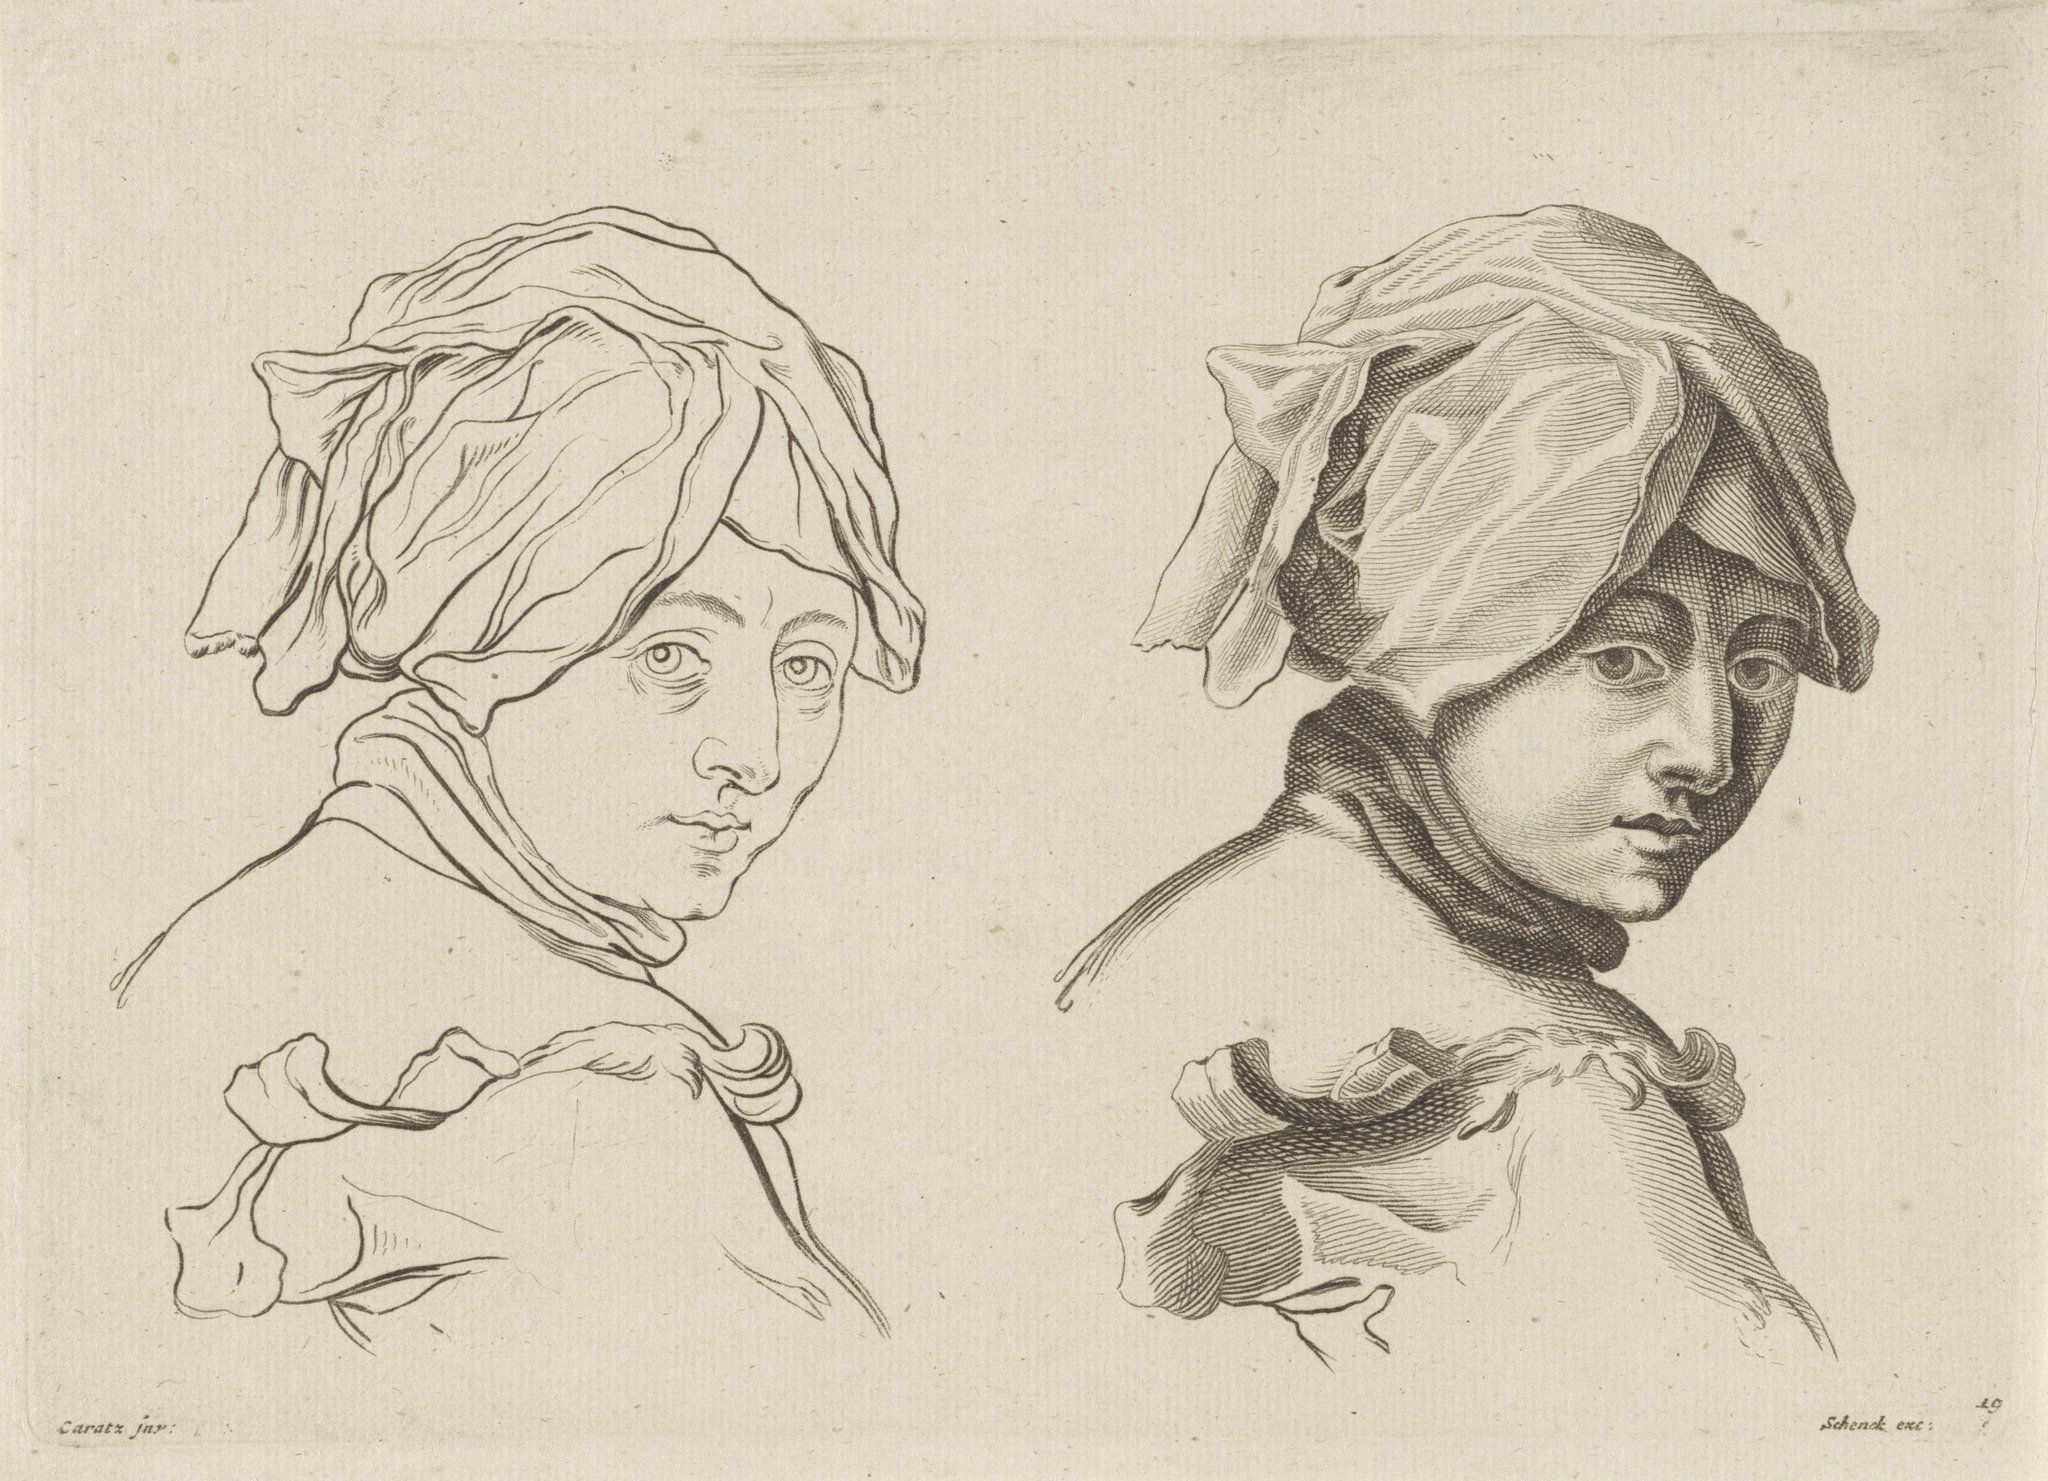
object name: print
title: Figuren naar Annibale Carracci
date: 1675-1711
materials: paper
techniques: engraving, etching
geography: amsterdam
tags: head (human), head-gear (with name)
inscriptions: collector's mark: Lugt 2228